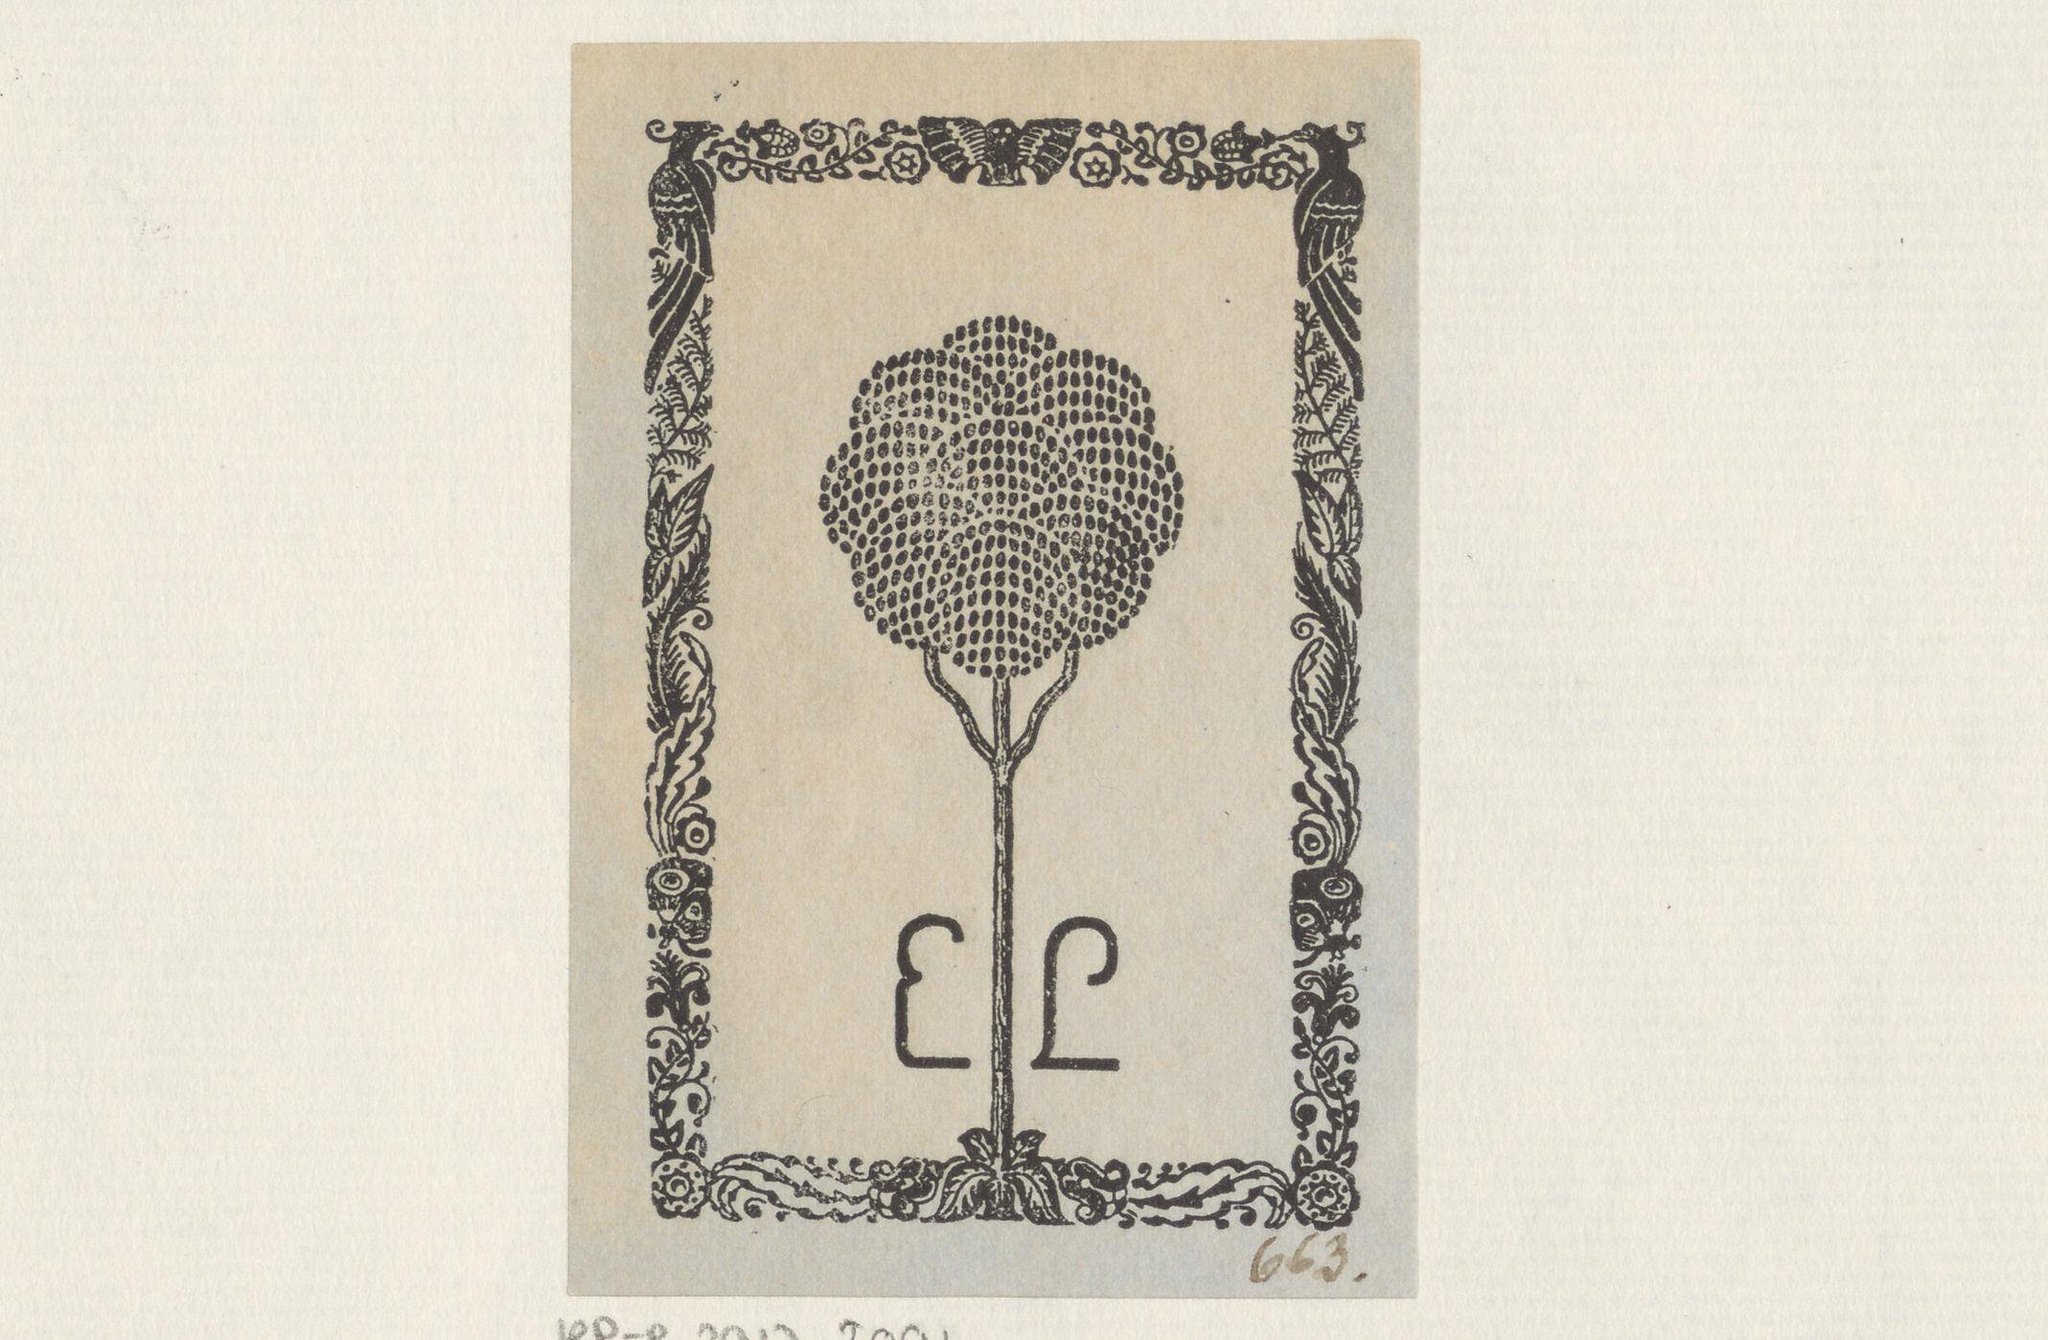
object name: bookplate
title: Ex libris van E.L.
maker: Anonymous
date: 1900-1999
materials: paper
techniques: woodcut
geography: italy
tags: trees, floral interlace ~ ornament, birds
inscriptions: inscription: ‘663.’